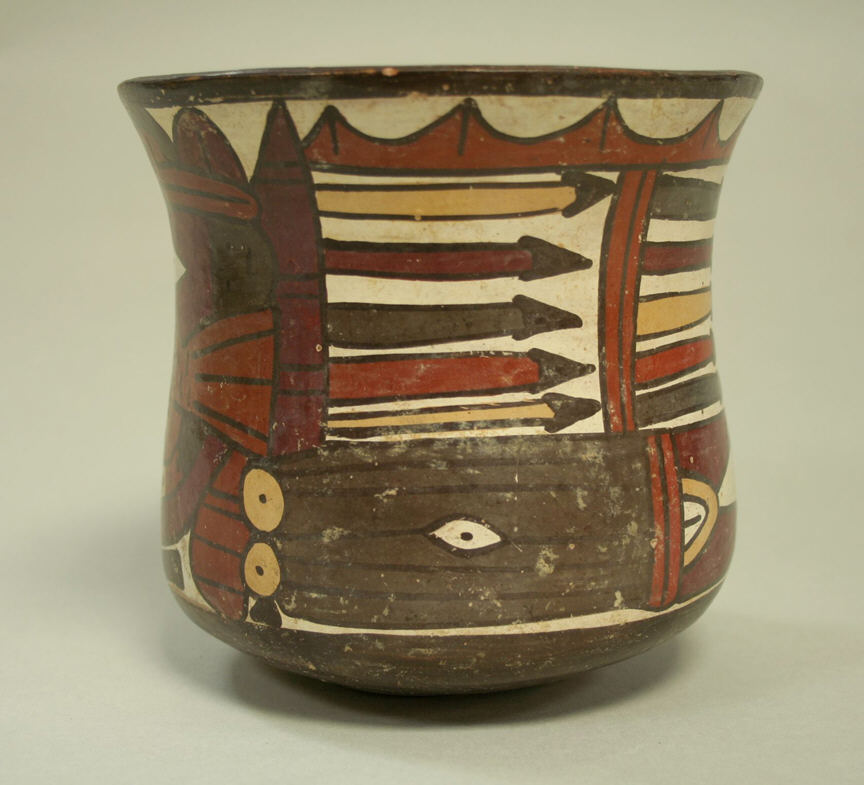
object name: bowl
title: Painted Jar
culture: nasca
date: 1-600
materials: ceramic, pigment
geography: peru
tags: faces